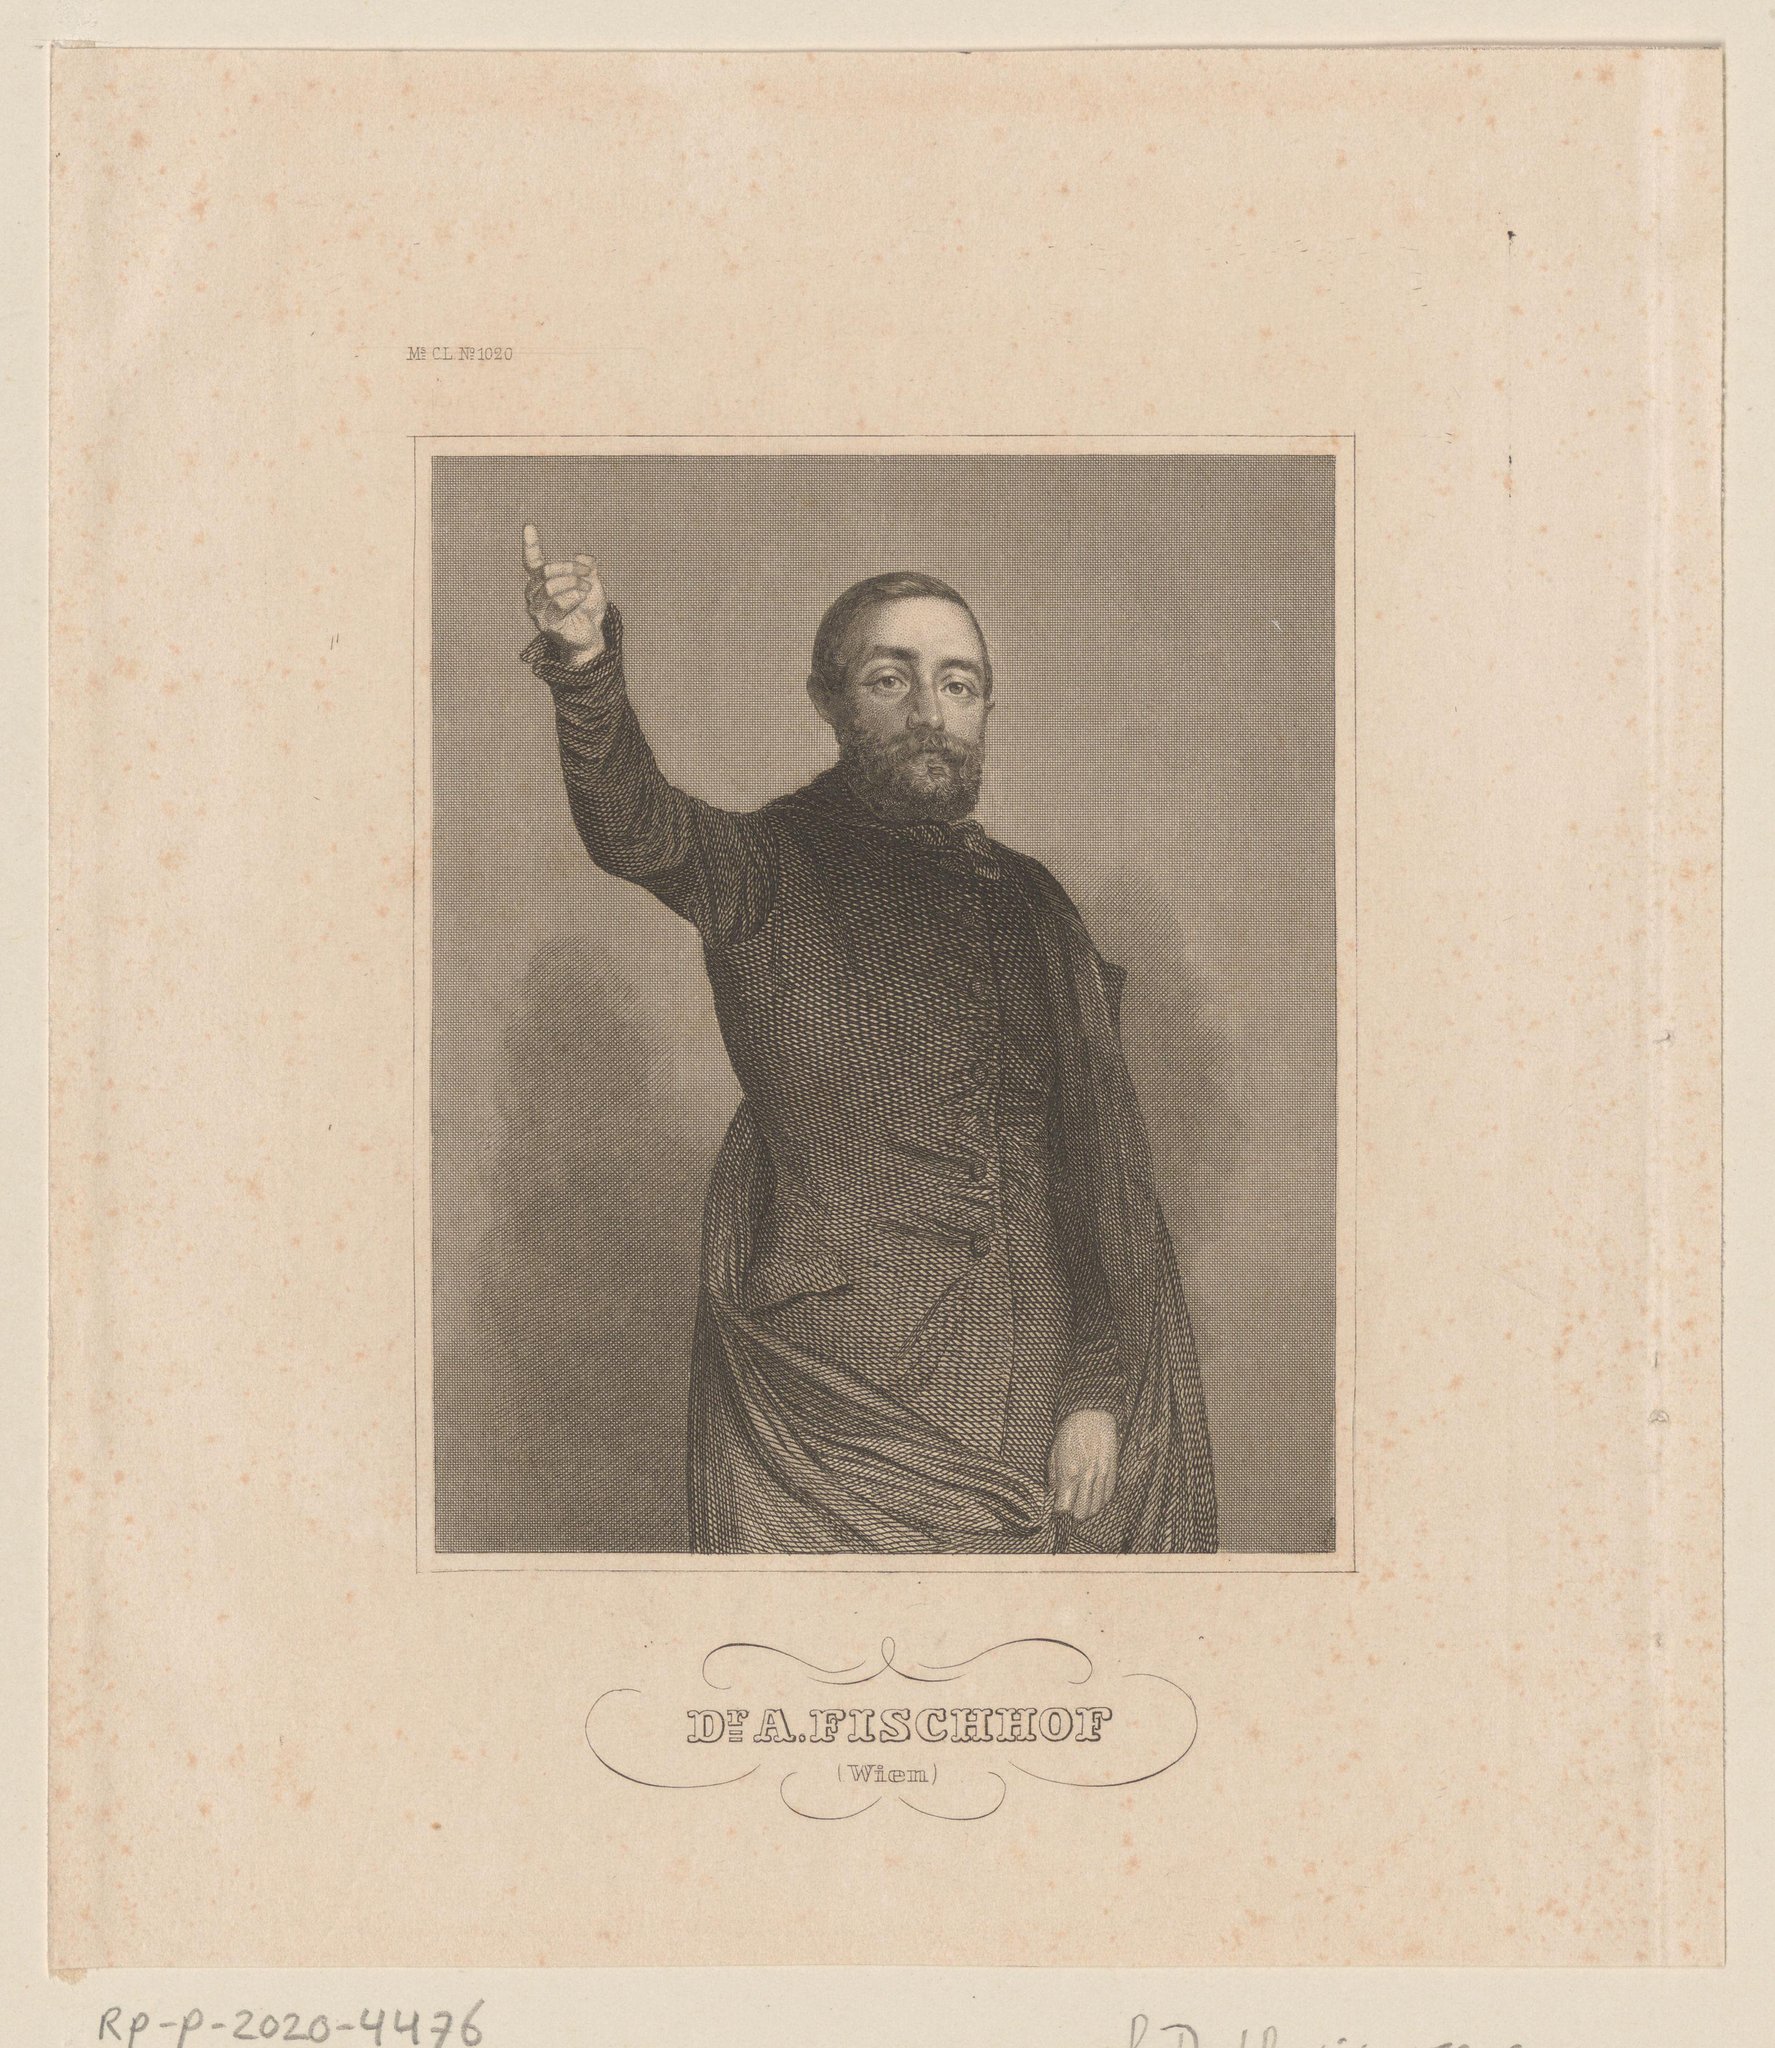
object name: print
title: Portret van Adolf Fischhof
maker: Anonymous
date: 1848-1893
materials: paper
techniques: etching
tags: politician, historical persons, politician, e.g. party leader, vienna